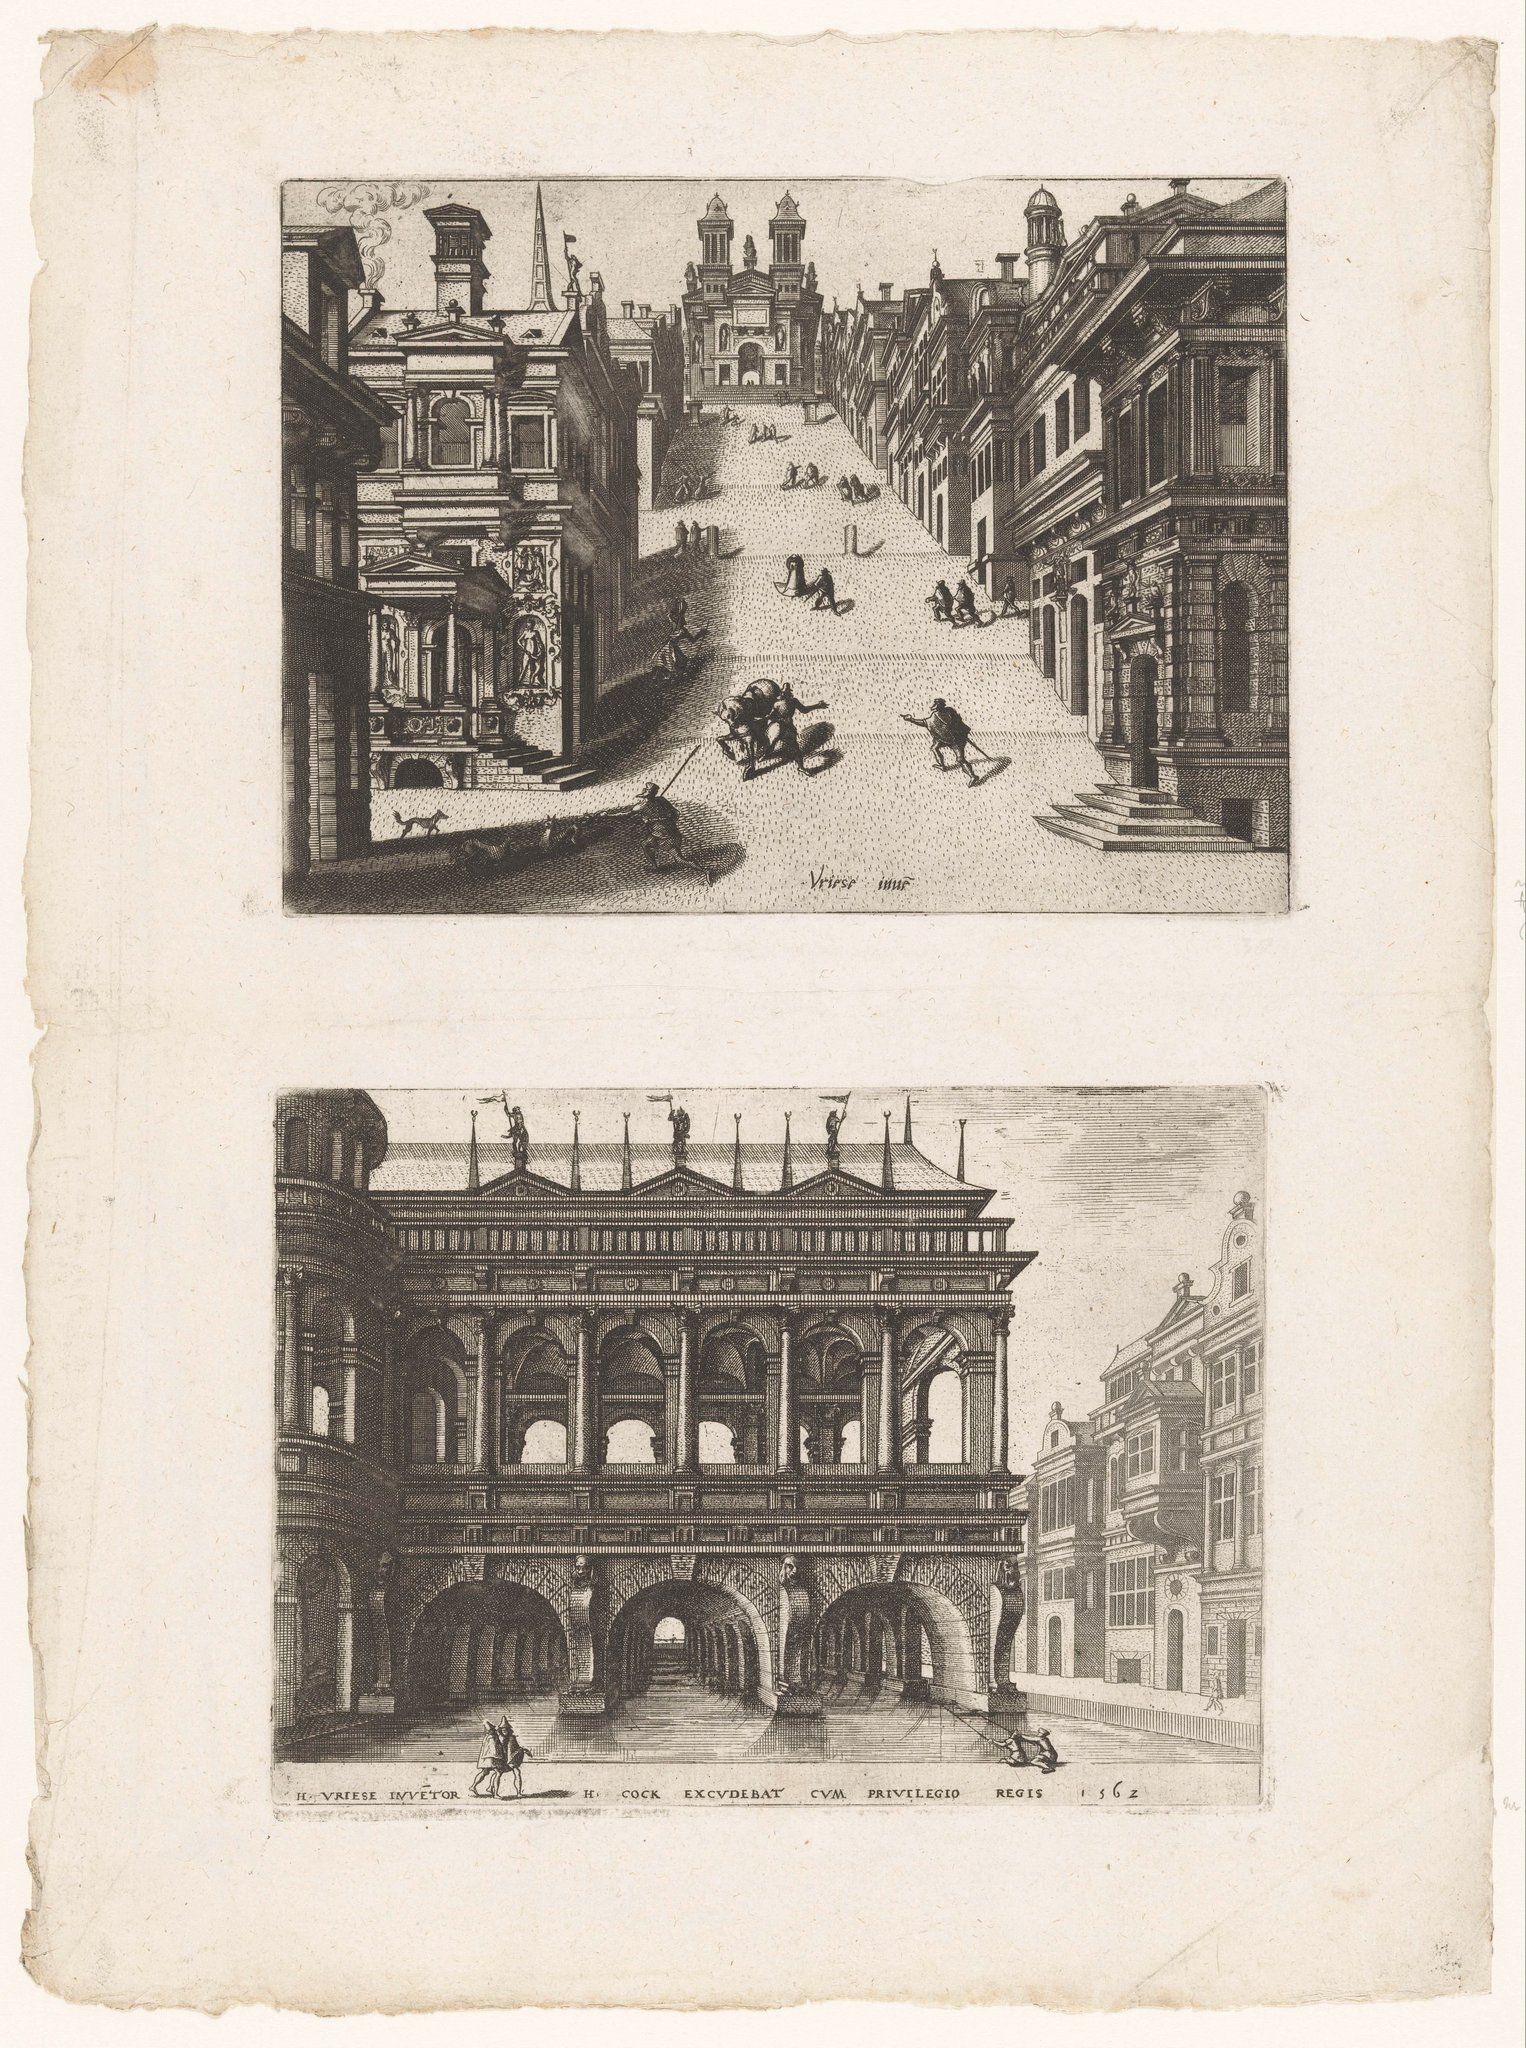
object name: print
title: Architectuurperspectieven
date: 1562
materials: paper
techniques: etching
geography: southern netherlands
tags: loggia, verandah, porch, street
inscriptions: collector's mark: Lugt 2760, collector's mark: Lugt 2228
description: Twee prenten op een blad. Boven: Een oplopende brede straat met monumentale bebouwing aan weerszijden. Aan het eind van de straat ligt een poortgebouw. Onder: Een loggia boven water, gebouwd op pijlers die met bogen aan elkaar verbonden zijn. Rechts staan stadshuizen, waarvan één met een erker.